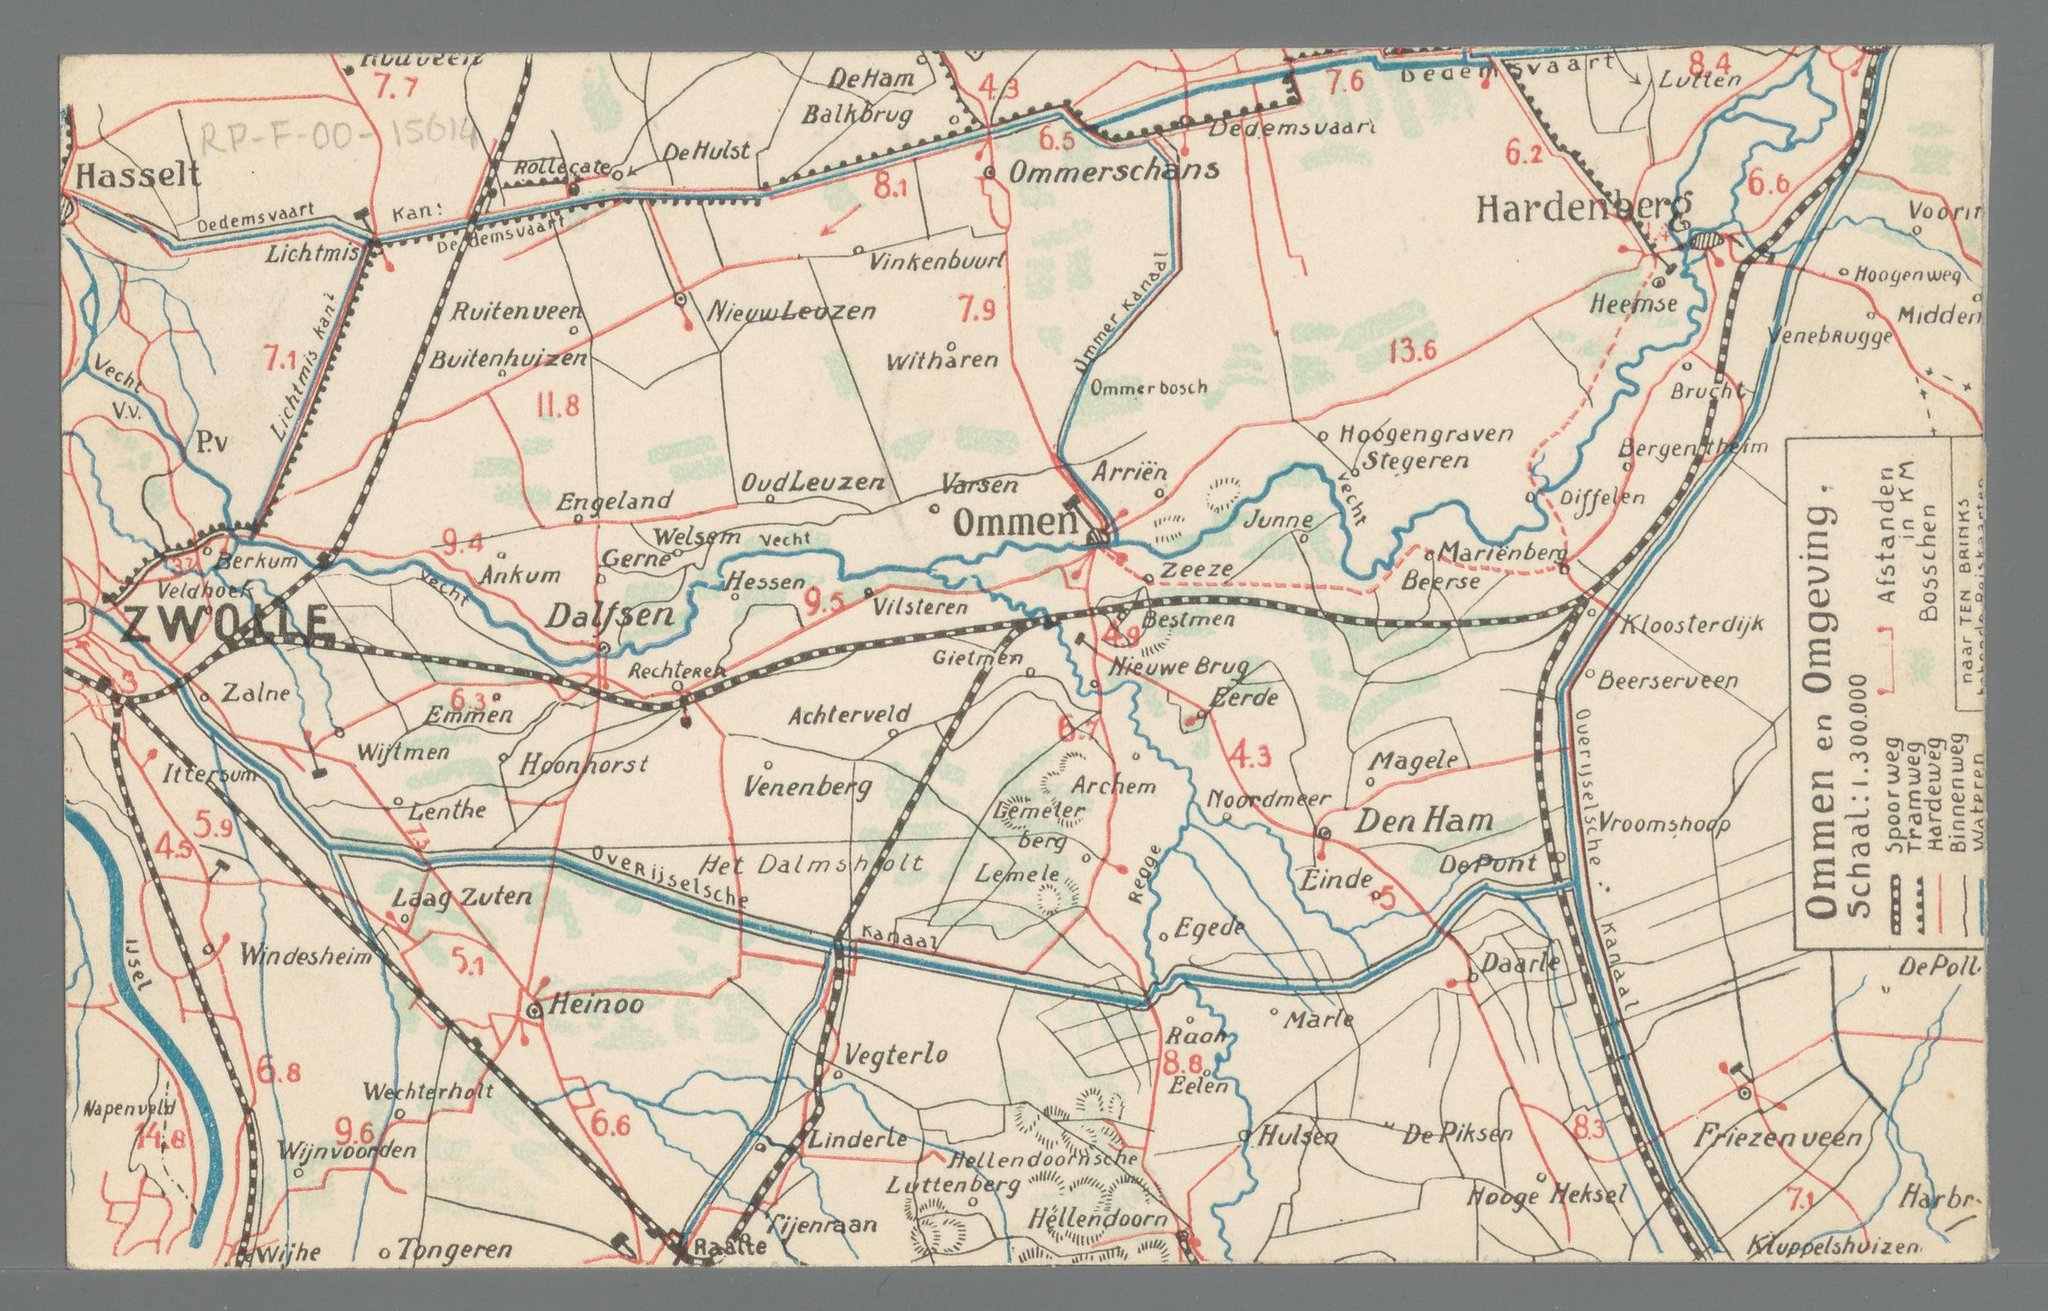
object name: photomechanical print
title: Bezoekt Ommen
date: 1905-1913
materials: cardboard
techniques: printing block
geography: ommen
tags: maps, atlases